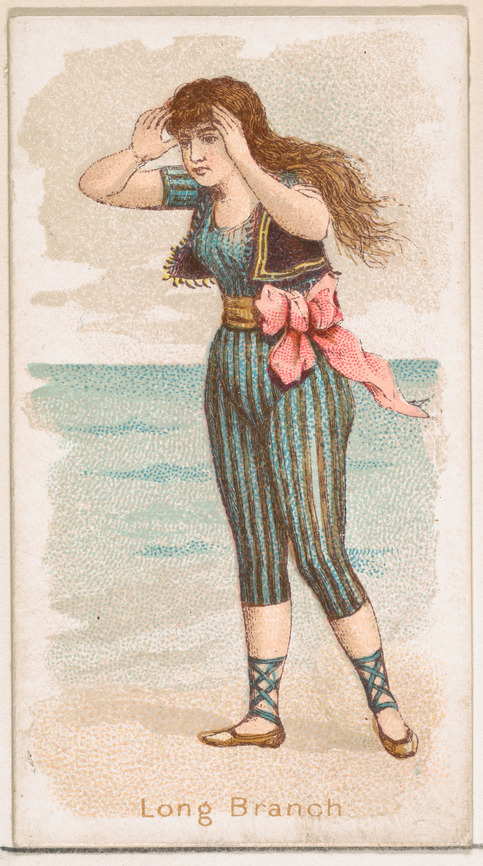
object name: print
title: Long Branch, from the Fancy Bathers series (N187) issued by Wm. S. Kimball & Co.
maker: william s. kimball & company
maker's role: publisher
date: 1889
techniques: color lithograph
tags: women